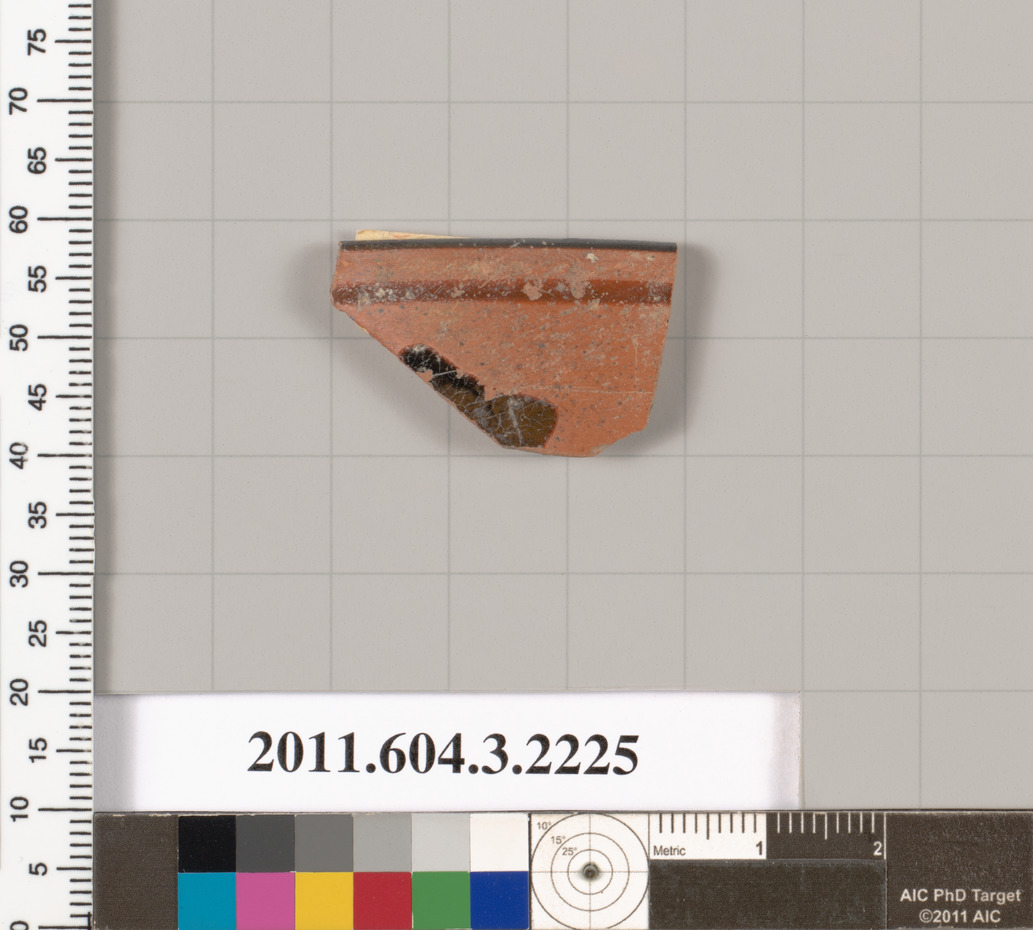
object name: kylix fragment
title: Terracotta fragment of a kylix (drinking cup)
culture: greek, attic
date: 525-501 BCE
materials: terracotta